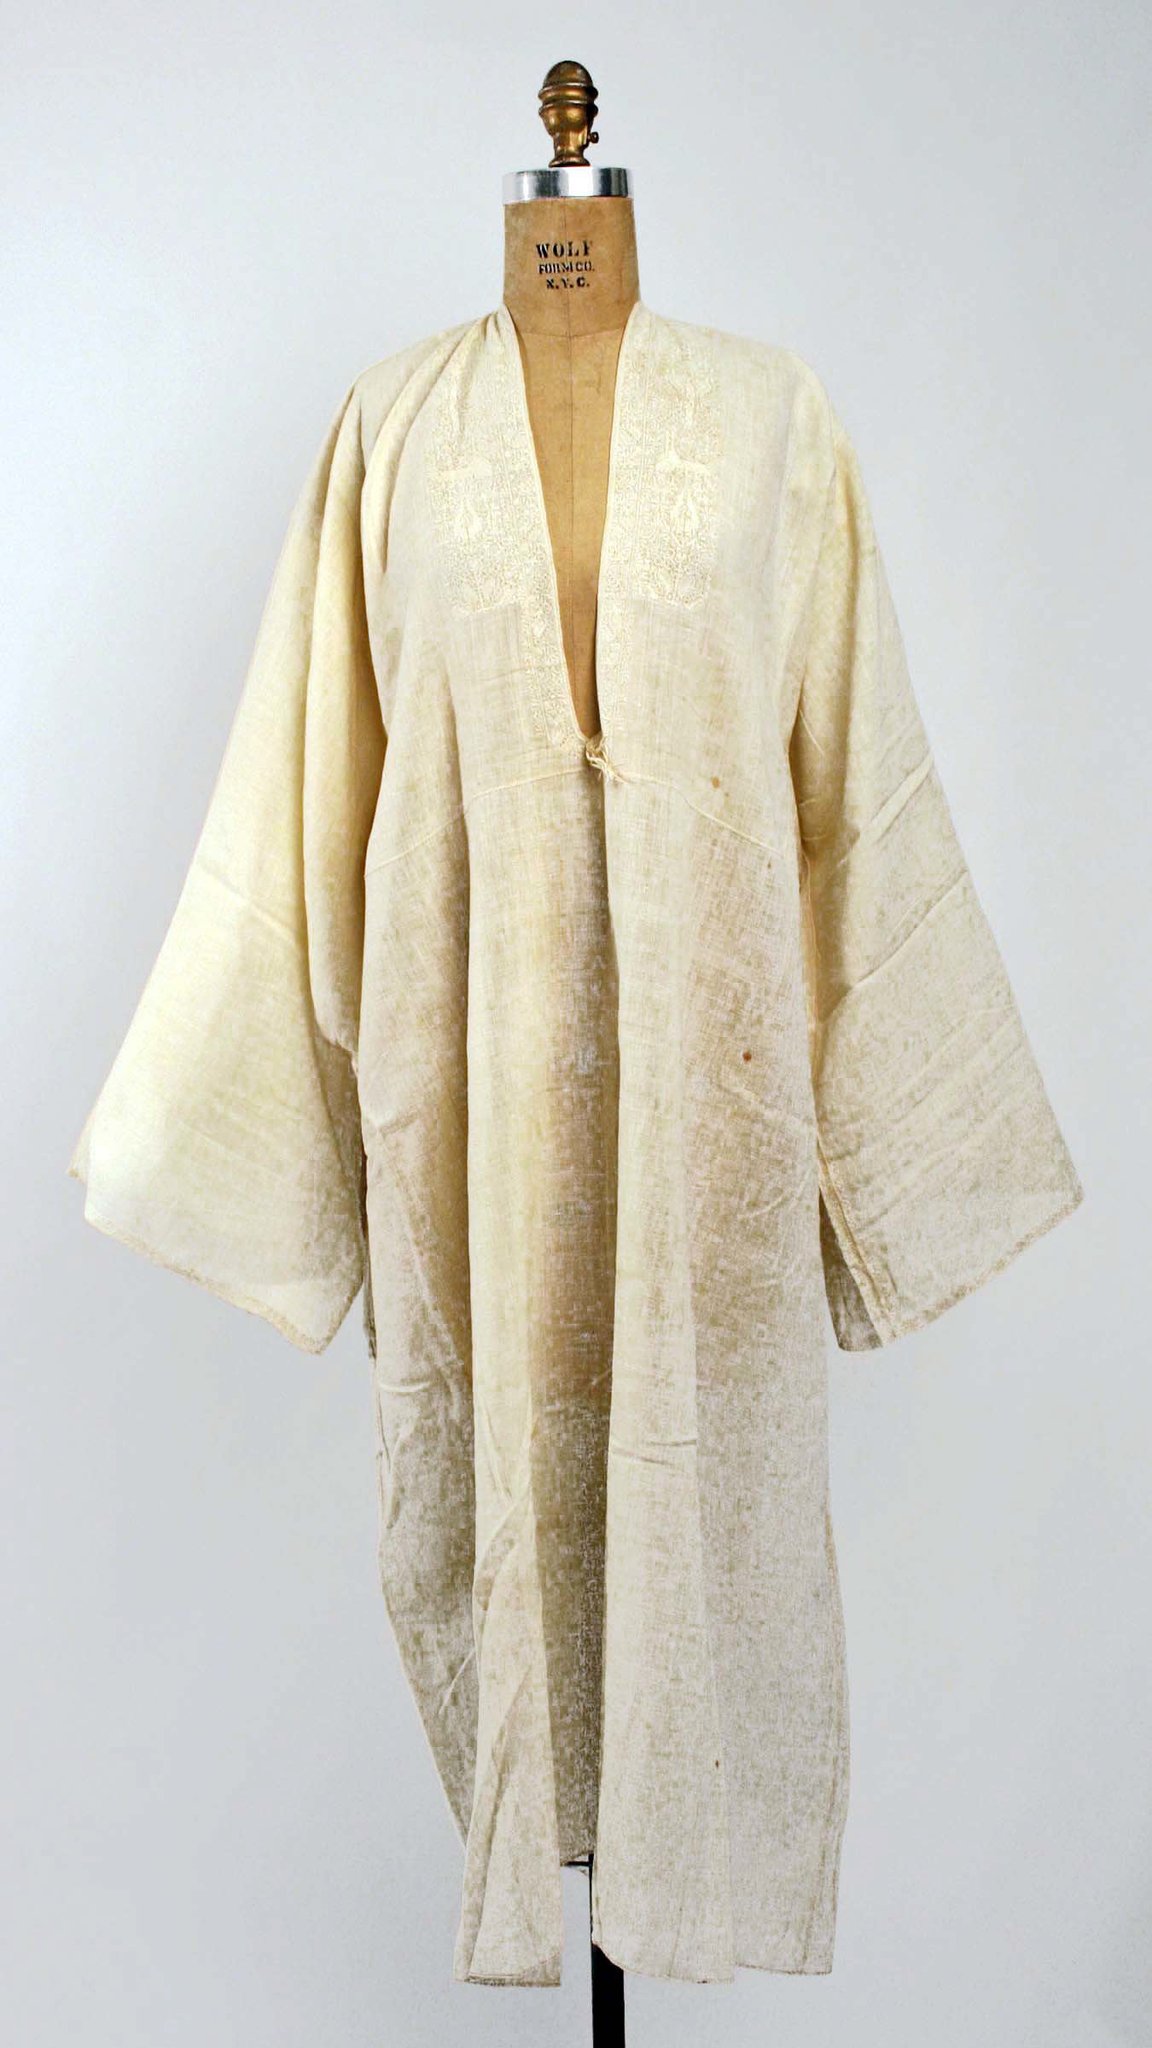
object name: underdress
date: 1701-1900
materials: linen